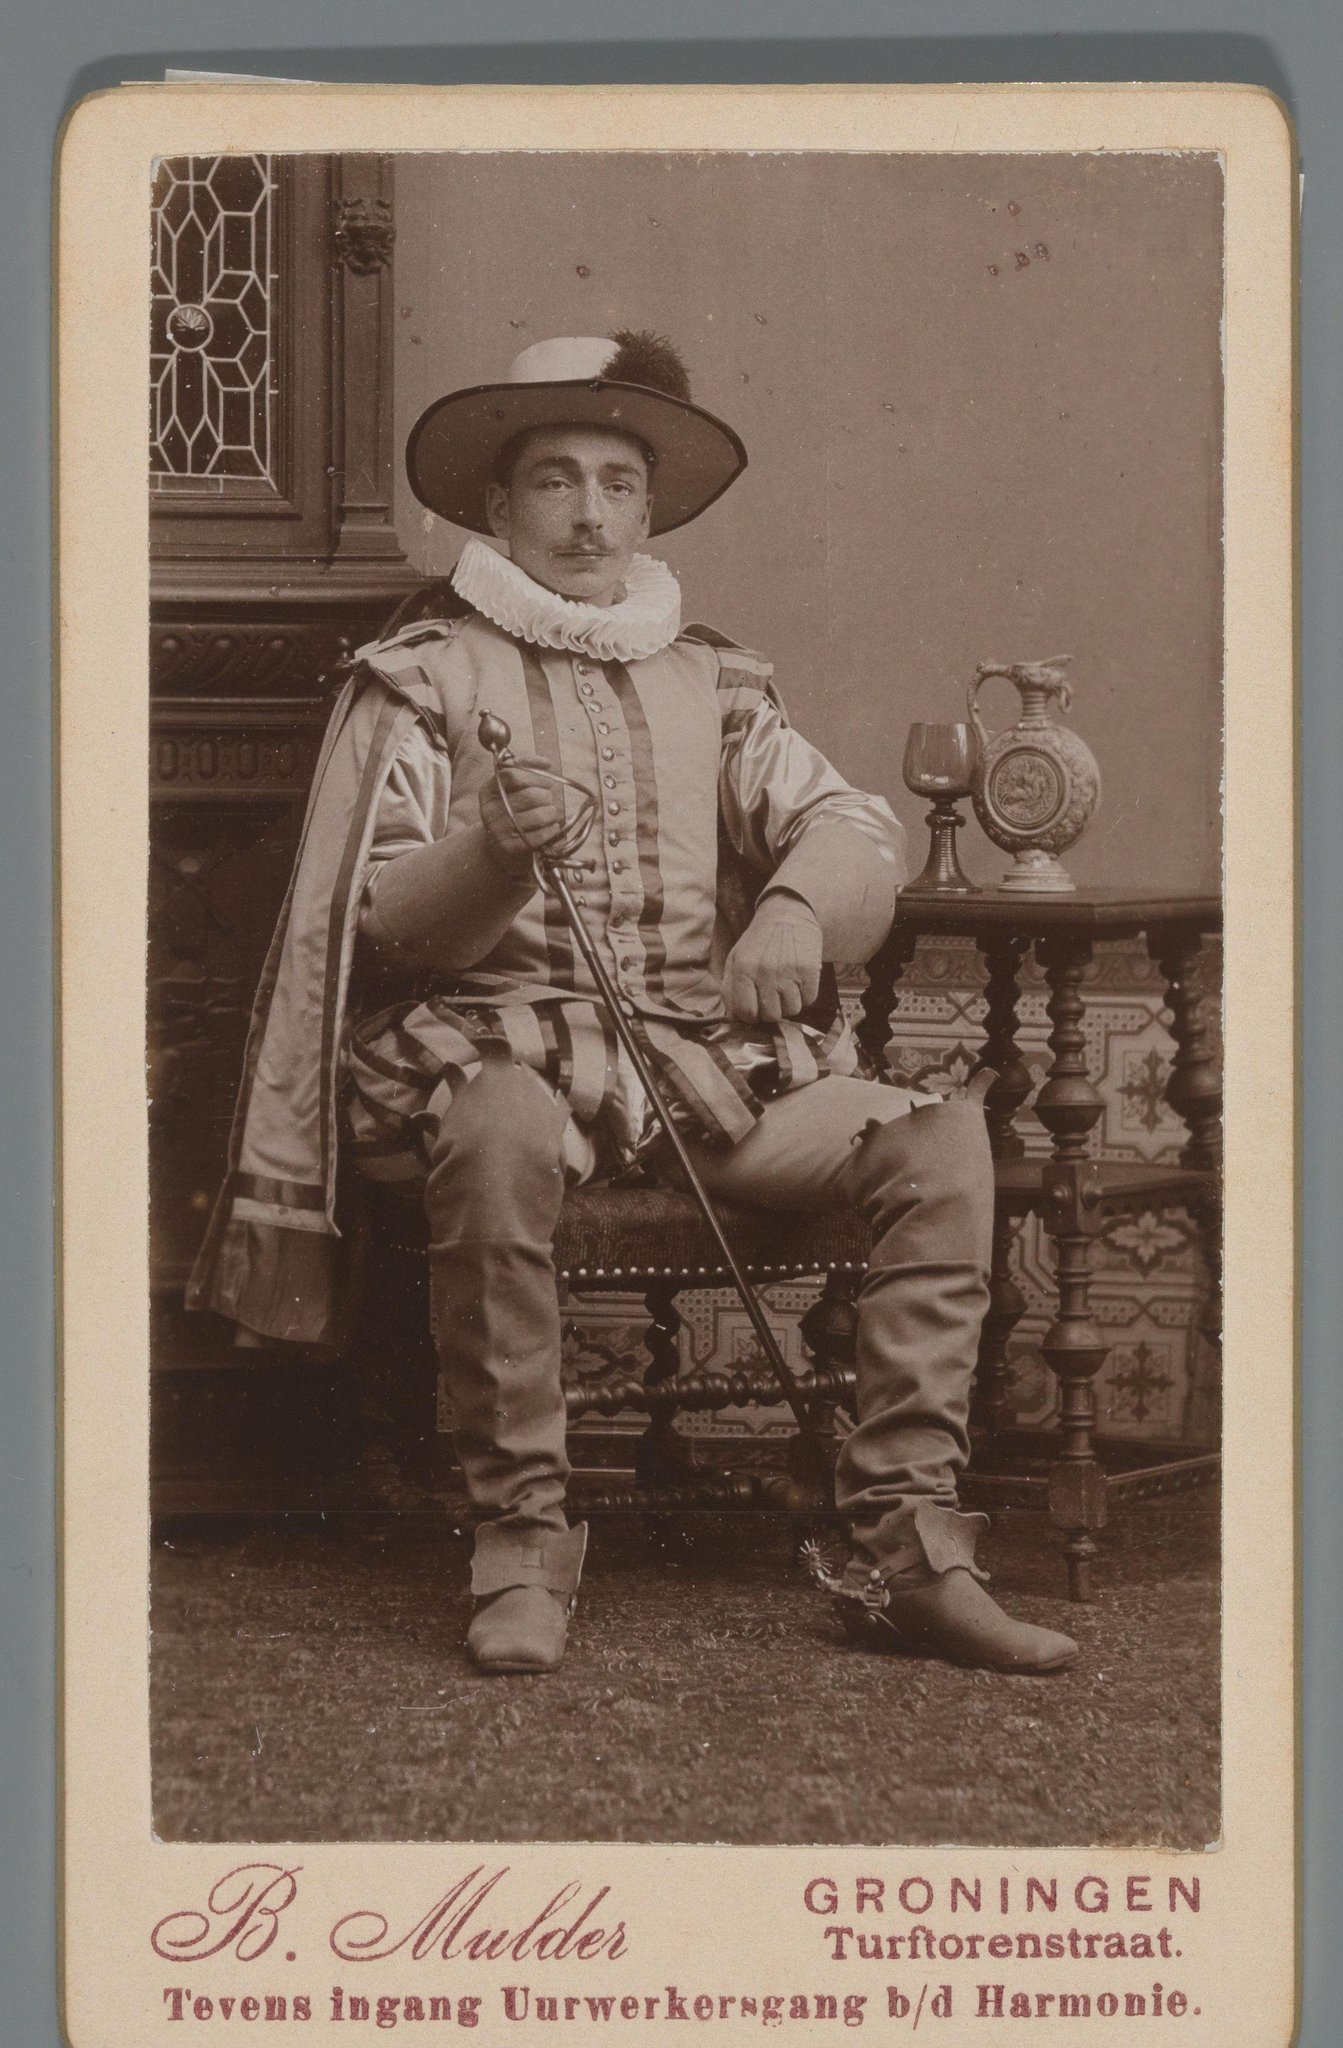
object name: photograph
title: Portret van een onbekende Groningse student in maskeradekostuum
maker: berend mulder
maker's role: fotograaf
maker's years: 1854-1926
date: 1886-1897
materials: paper, cardboard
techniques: collodion silver print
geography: groningen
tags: students' pageant, costumes used in pageants, anonymous historical person portrayed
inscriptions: inscription: ‘B. Mulder/ Groningen/ Turftorenstraat./ Tevens ingang Uurwerksgang b/d Harmonie’